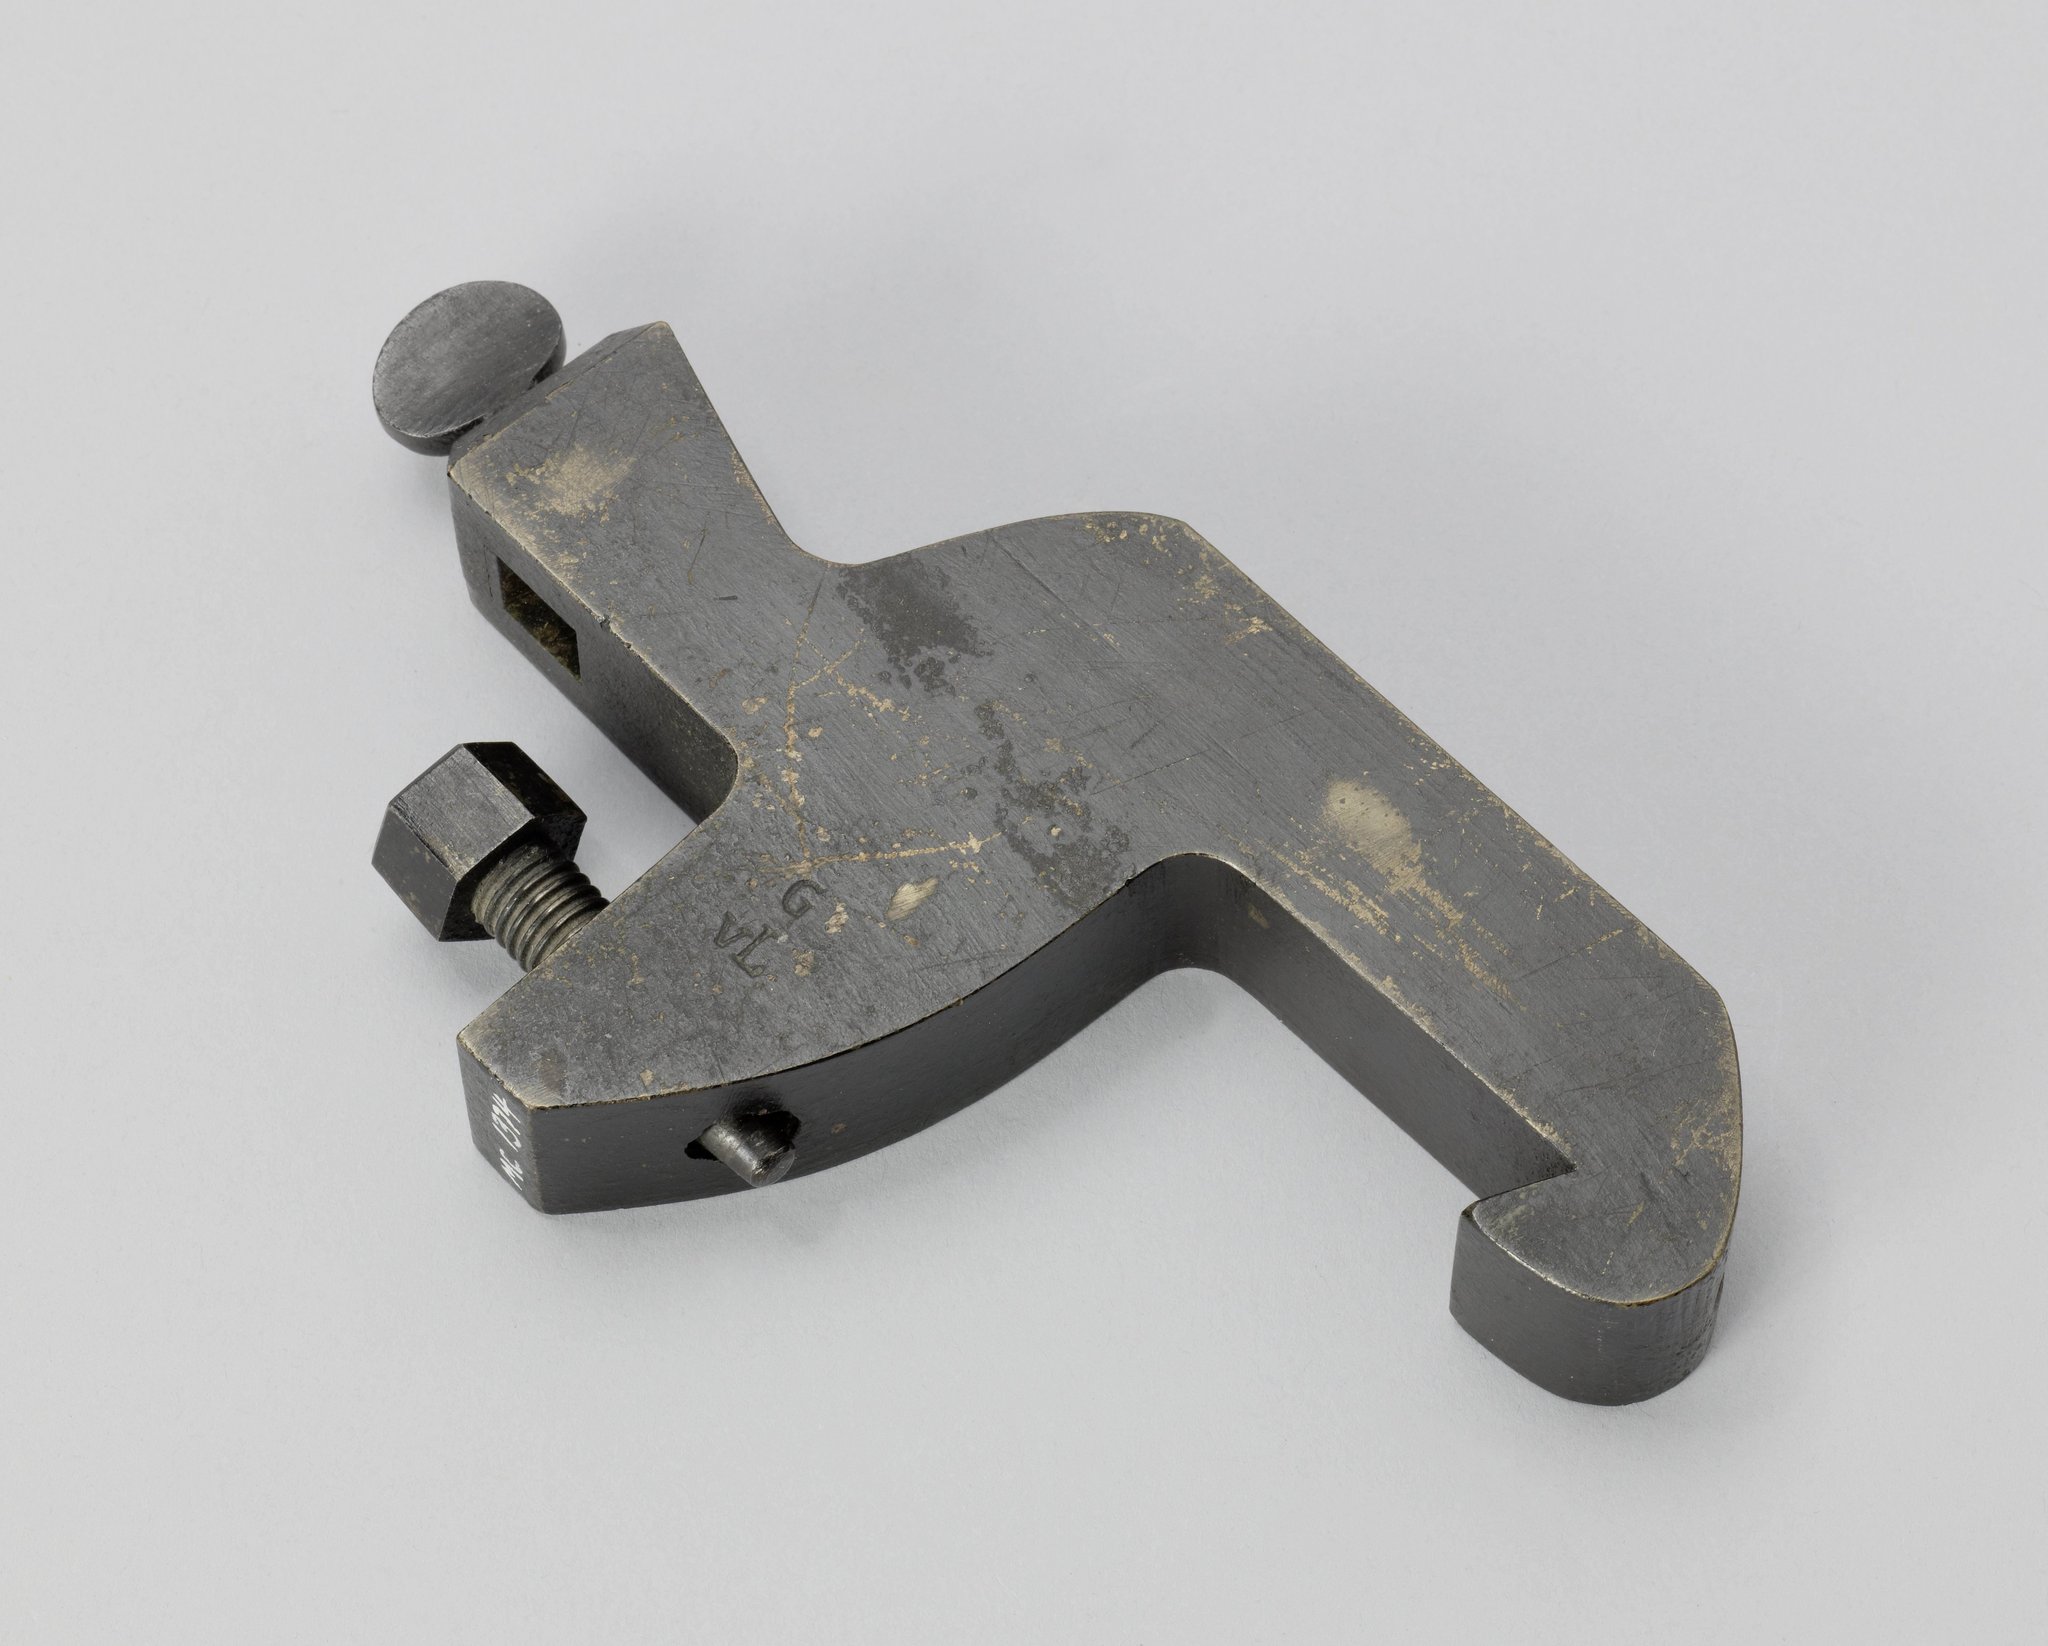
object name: demonstration model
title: Support of a Tangent Sight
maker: Anonymous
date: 1860-1870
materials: brass, iron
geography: netherlands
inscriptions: inscription, near the screw, stamped: ‘G / vL 2’, inscription, centre, stamped: ‘2 KUST’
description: Opzetsteun die tegen de achterkant van de slotverhevenheid gemonteerd wordt, met een haak in een vierkante inkeping in de slotsteun grijpend en van achter met een schroef aangedraaid. De opzetstang wordt in een nok acherop de steun geplaatst, naar voren hellend, en kan op en neer bewegen. Het opschrift verwijst naar geschut voor een kustbatterij. De twee opzetstangen, beschreven onder nr. NG-MC-1889-29, passen in deze steun. Demonstratiemodel of proefmodel.